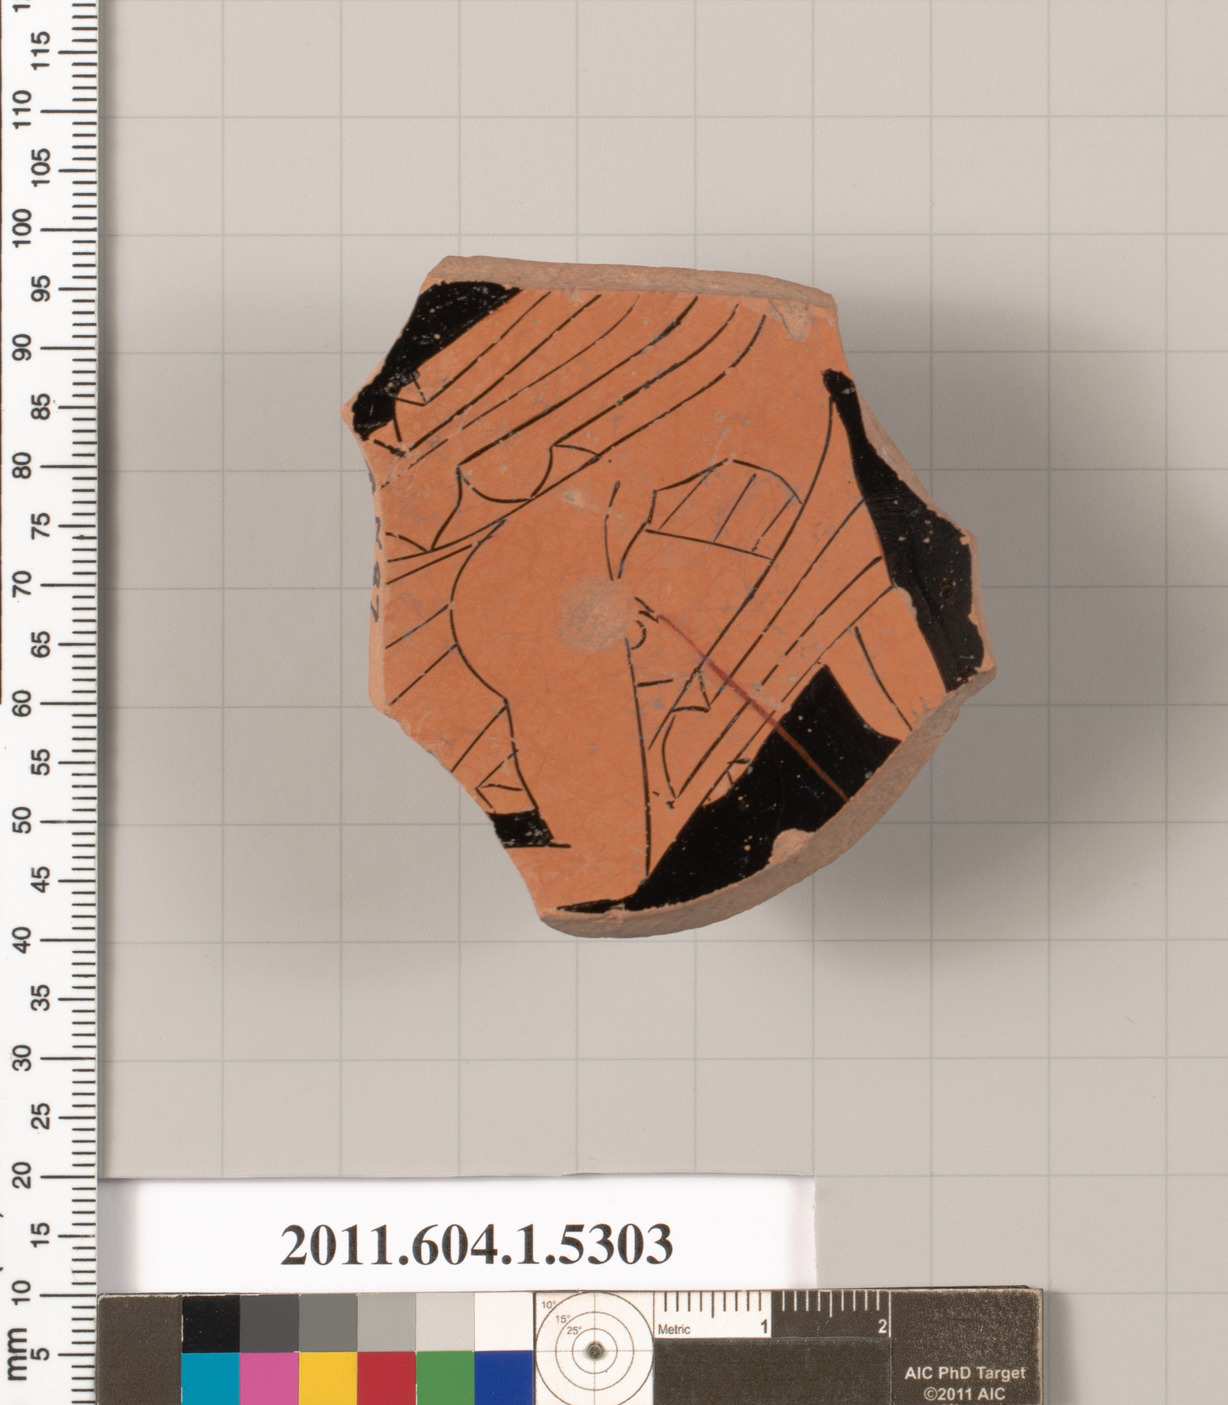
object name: kylix fragment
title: Terracotta fragment of a kylix (drinking cup)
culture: greek, attic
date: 500-480 BCE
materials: terracotta